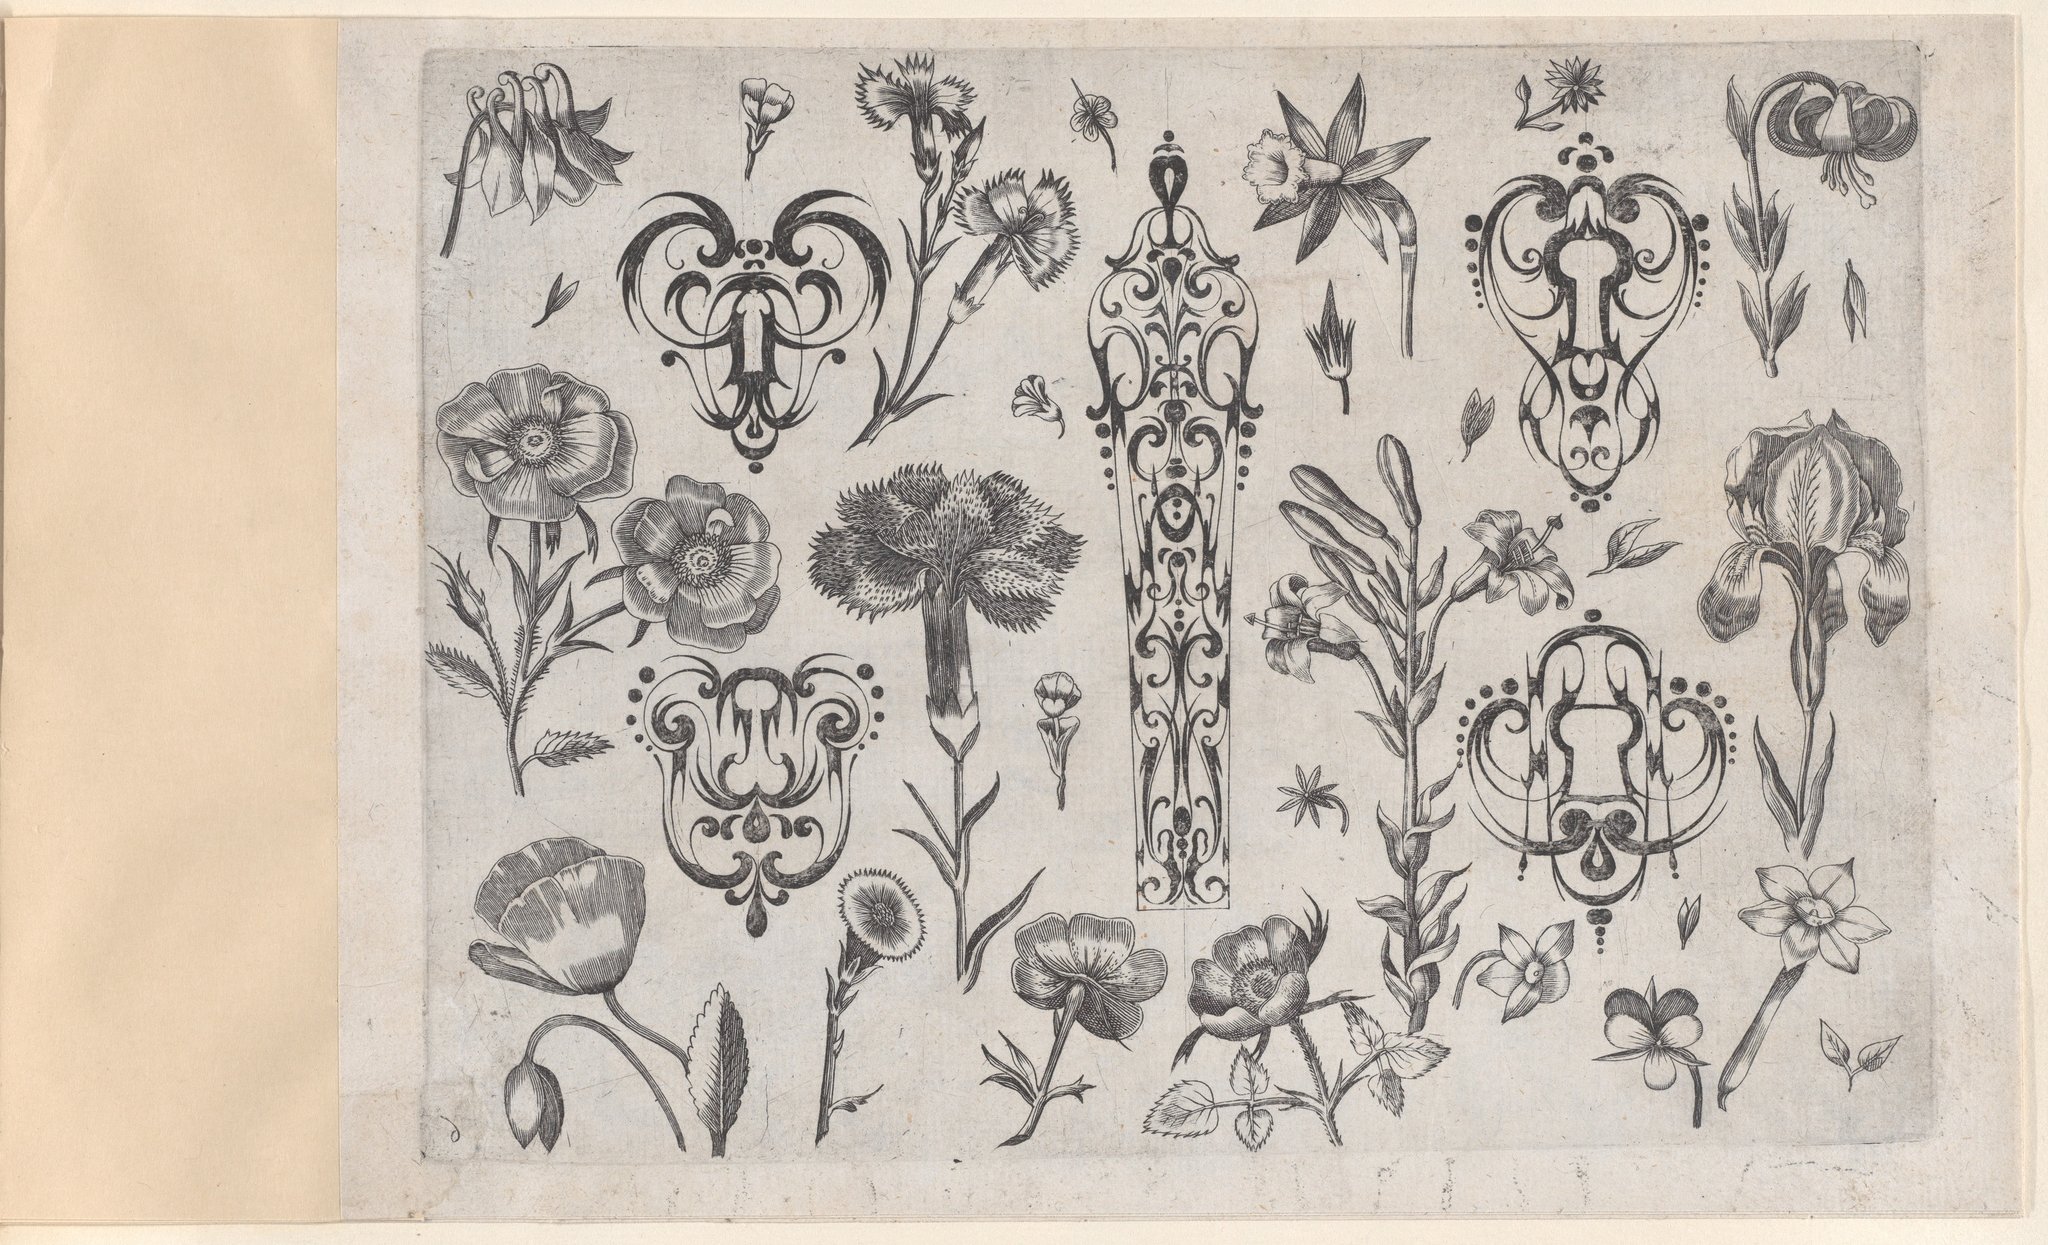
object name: album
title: Blackwork Designs with Flowers, Plate 6 from a Series of Blackwork Ornaments combined with Figures, Birds, Animals and Flowers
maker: meinert gelijs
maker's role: artist and engraver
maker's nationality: dutch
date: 1622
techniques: embroidery, engraving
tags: ornament